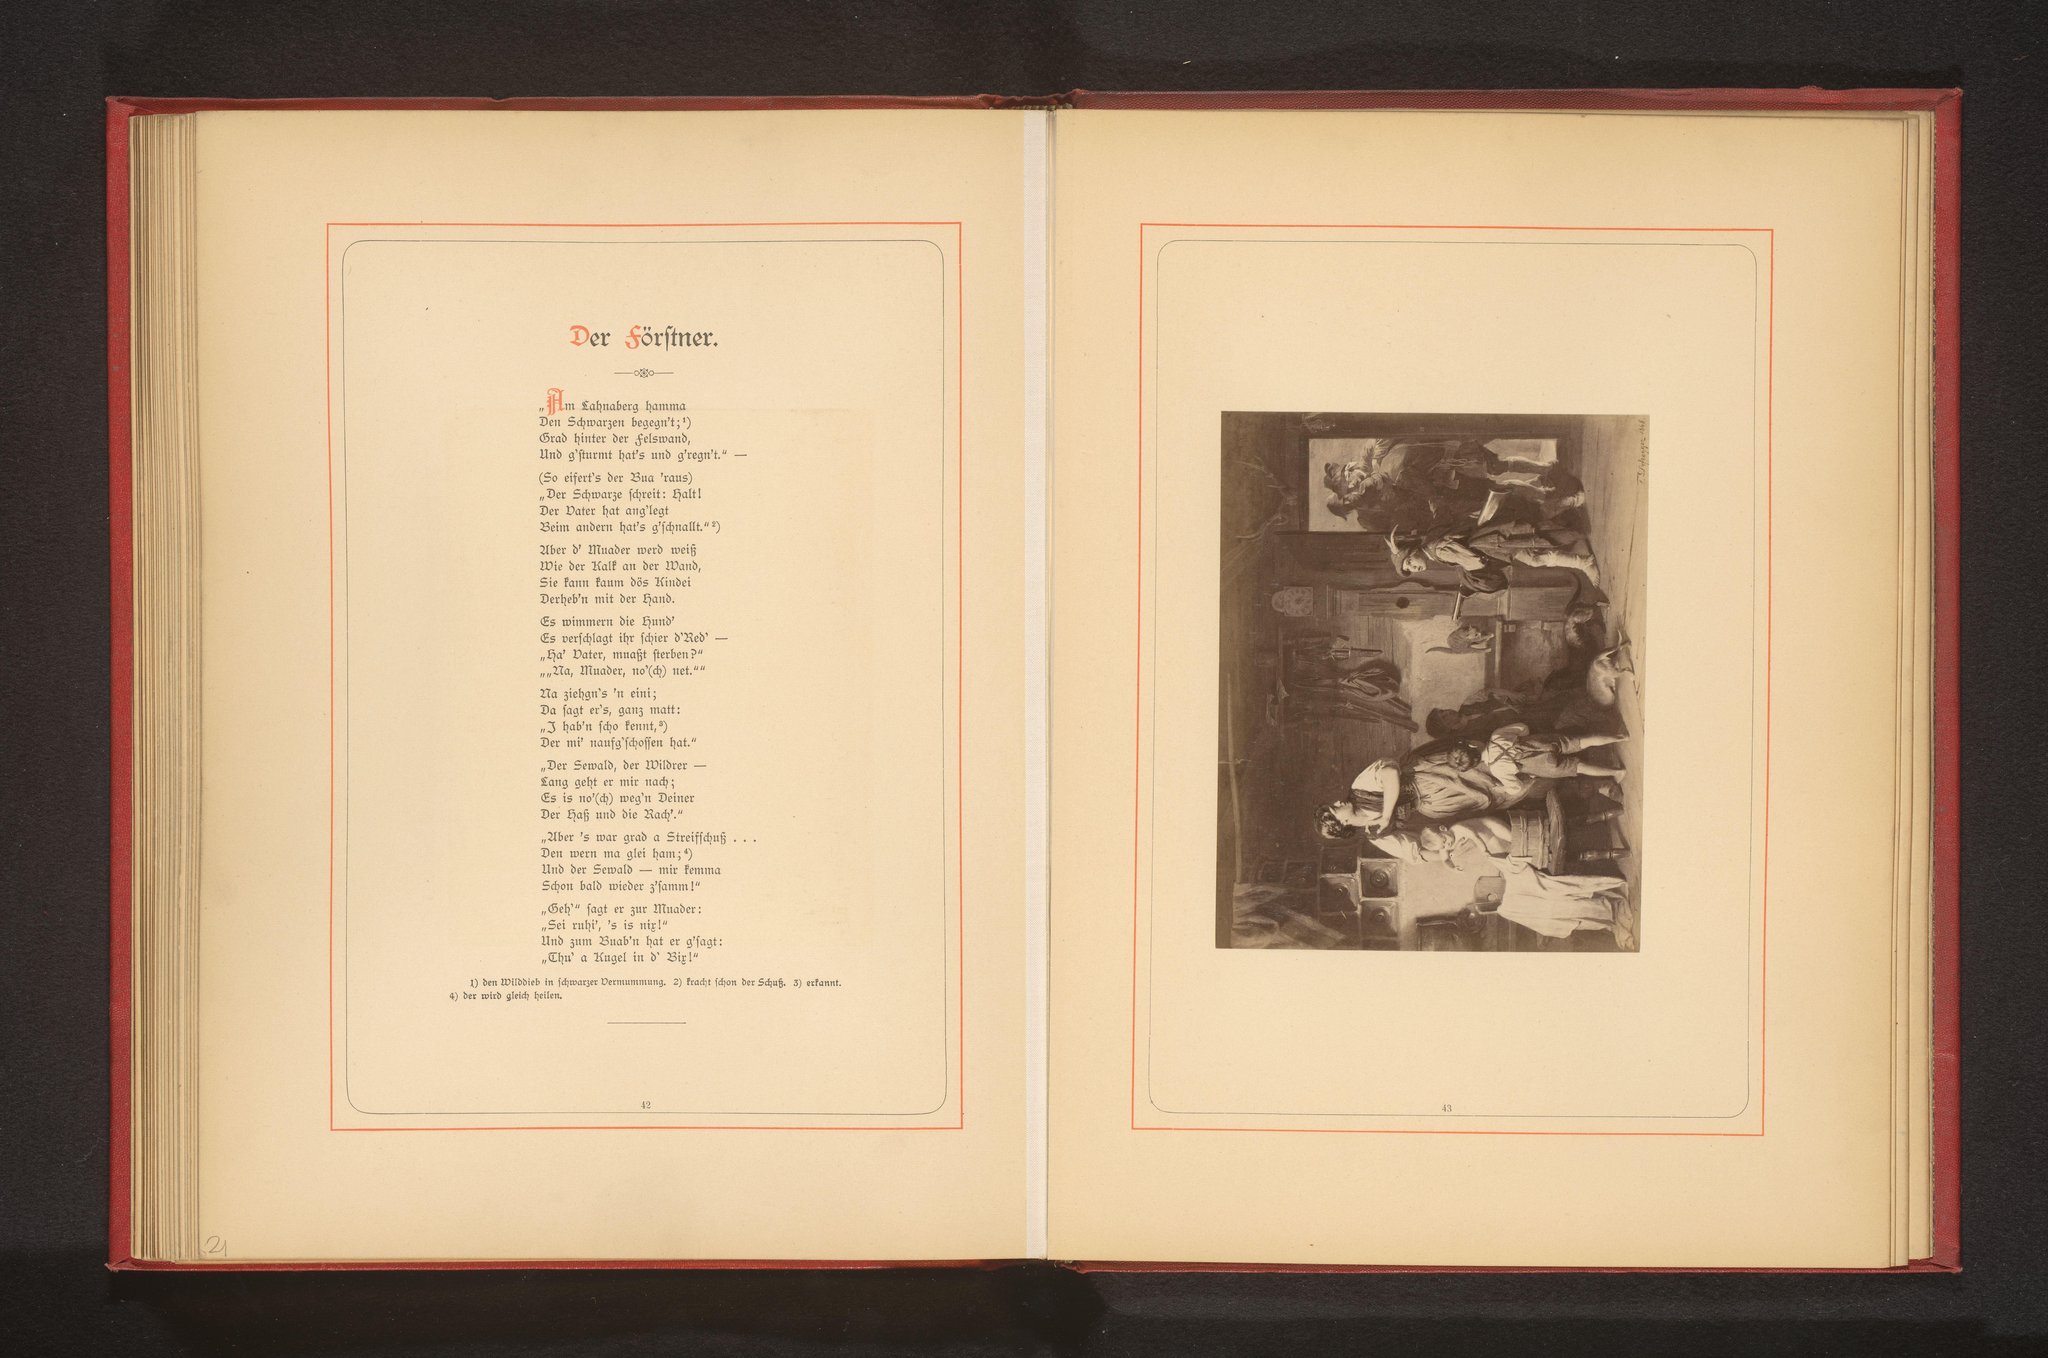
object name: reproduction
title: Fotoreproductie van een schilderij, voorstellende een moeder baadt haar kind, terwijl een gezelschap binnenkomt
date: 1868-1883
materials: photographic support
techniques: albumen print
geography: germany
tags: tub-bath, family life at home